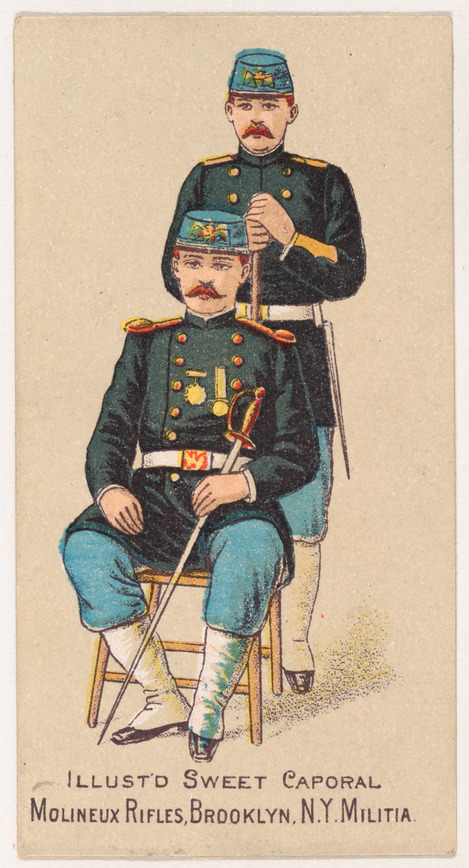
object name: print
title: Molineux Rifles, Brooklyn, New York Militia, from the Military Series (N224) issued by Kinney Tobacco Company to promote Sweet Caporal Cigarettes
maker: kinney brothers tobacco company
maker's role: publisher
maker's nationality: american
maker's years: 1869-2011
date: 1888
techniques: color lithograph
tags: military,swords,men